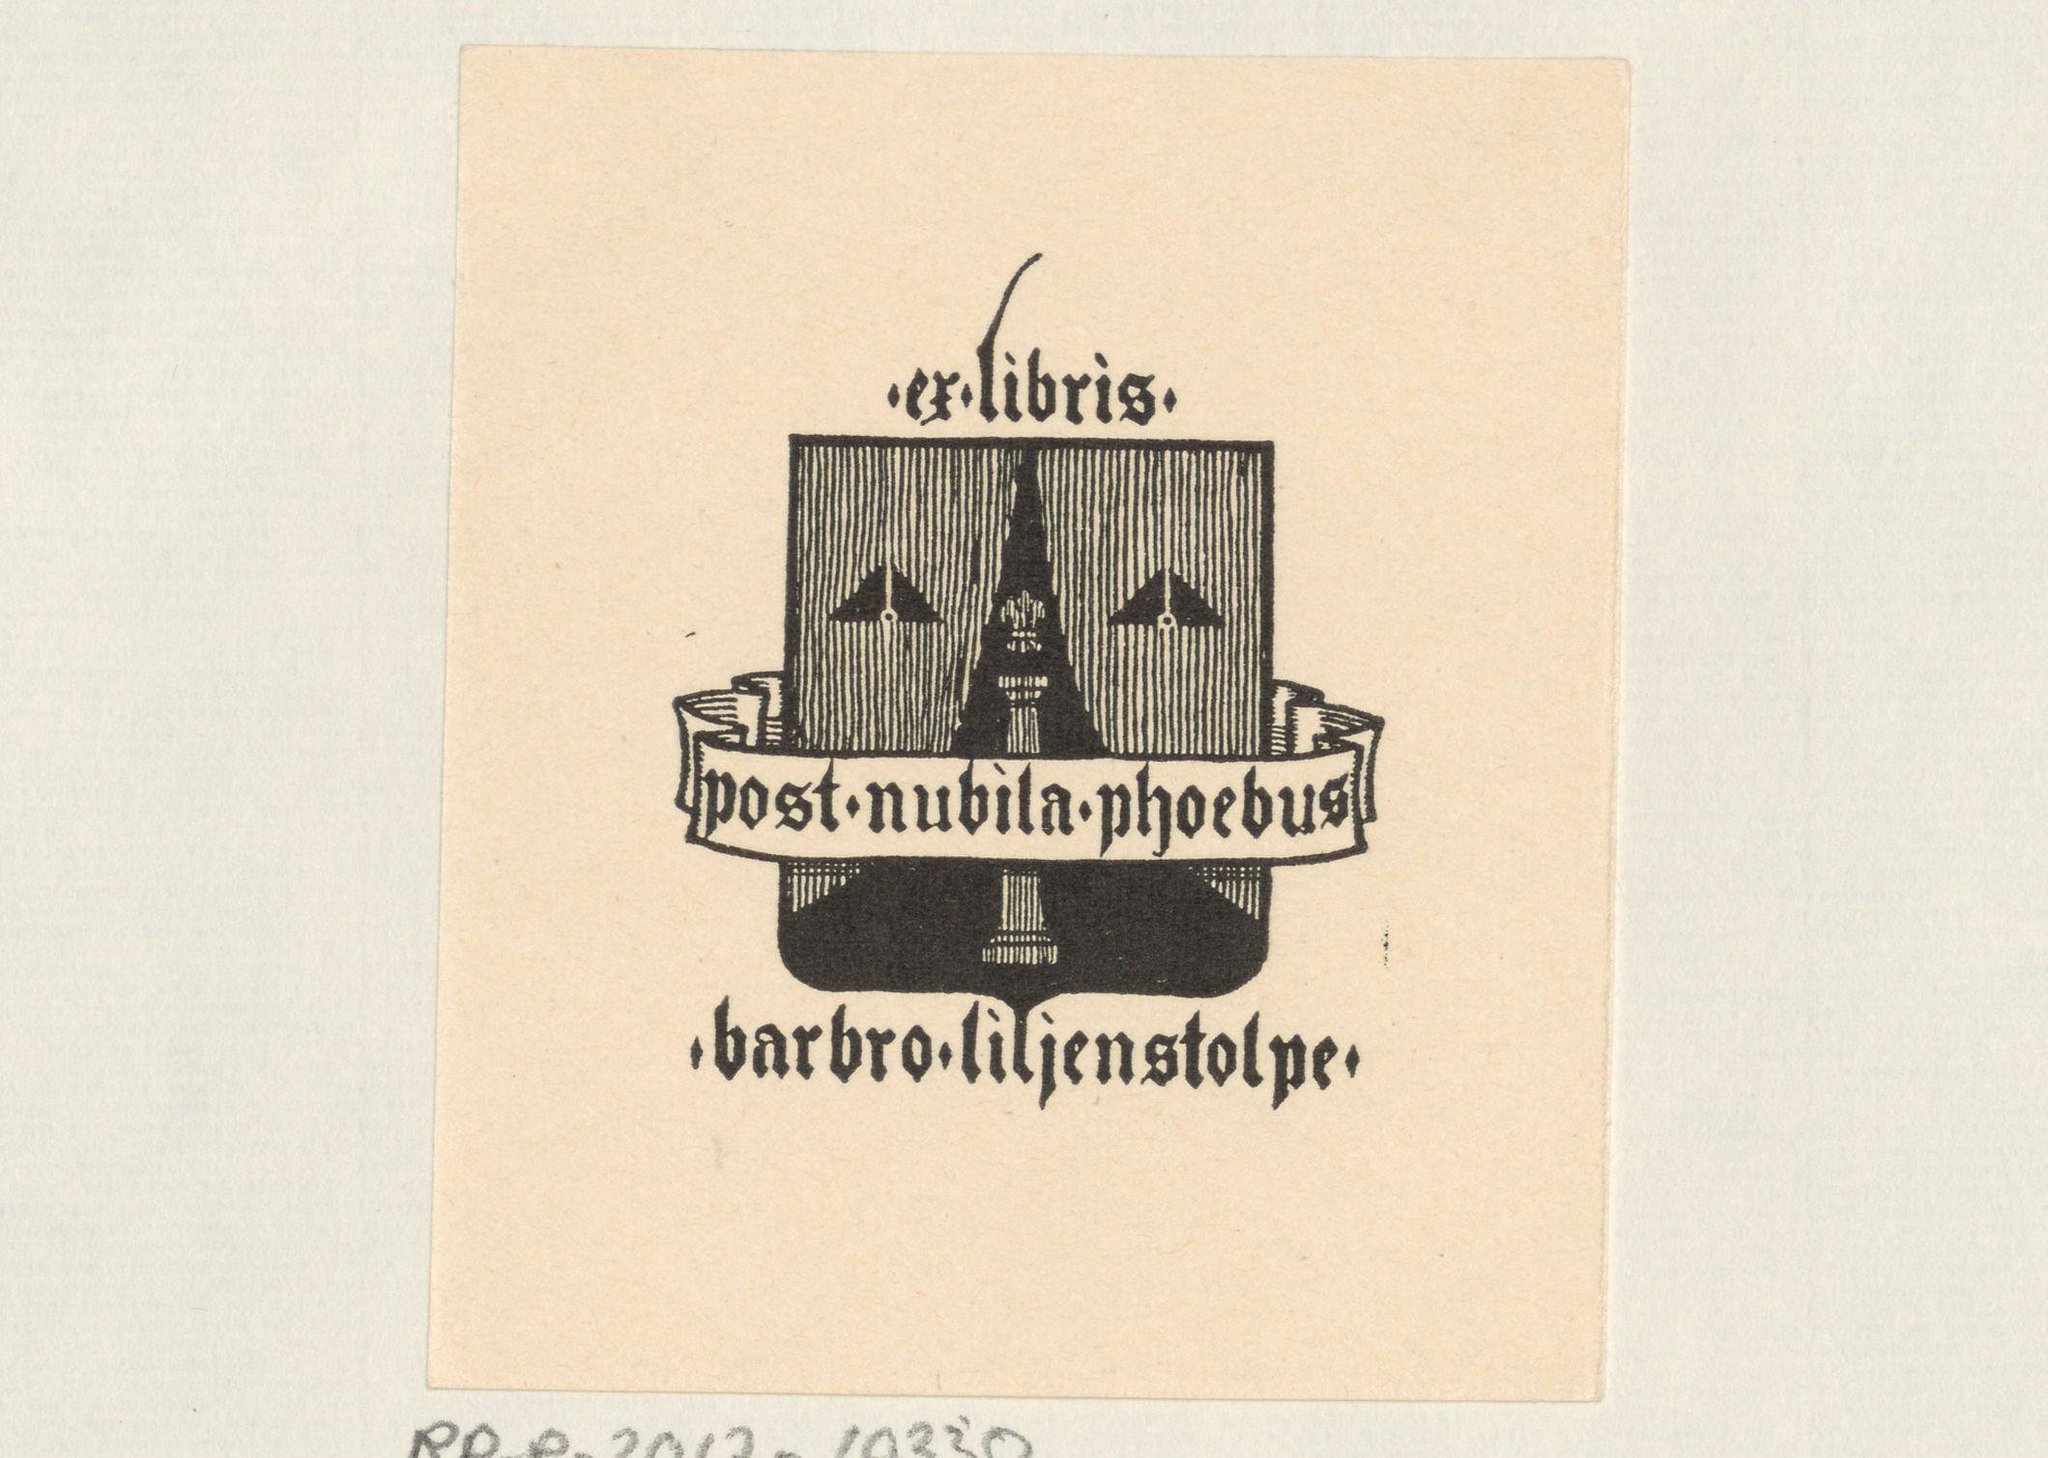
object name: bookplate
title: Post nubila Phoebus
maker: Anonymous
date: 1922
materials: paper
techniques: printing block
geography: germany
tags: column, pillar ~ architecture, armorial bearing, heraldry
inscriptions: inscription: ‘E. Holzschisz 1922 Tysklan’